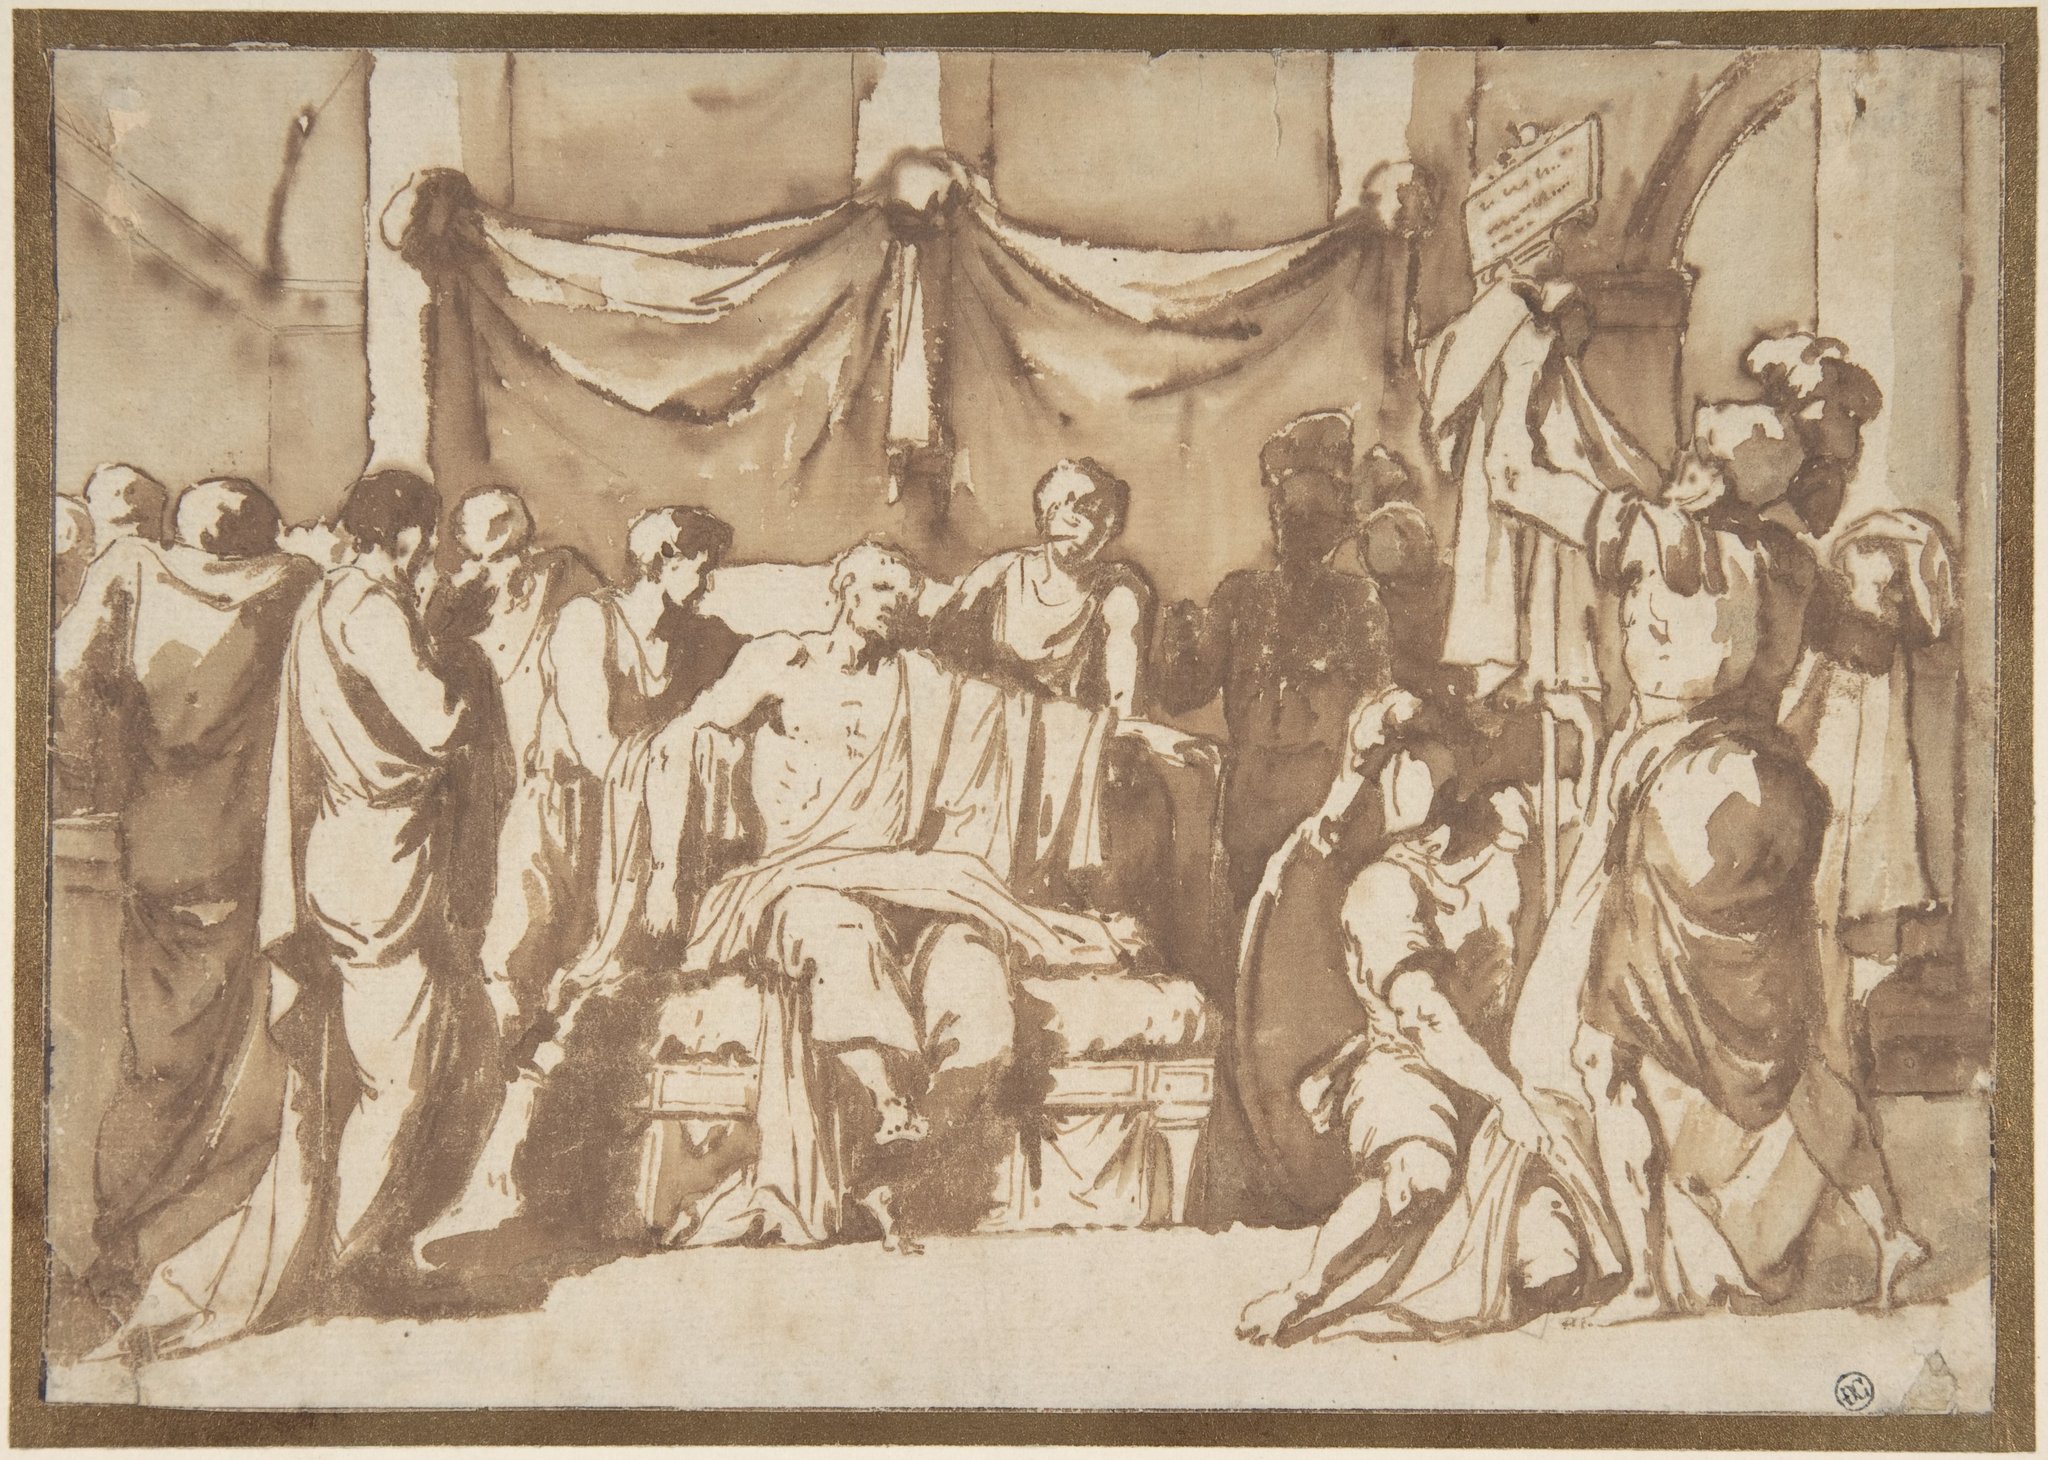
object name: drawing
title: The Death of Seneca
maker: pierre peyron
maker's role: artist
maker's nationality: french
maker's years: 1744-1814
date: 1773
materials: ink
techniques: brush, pen, wash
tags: men,women,death